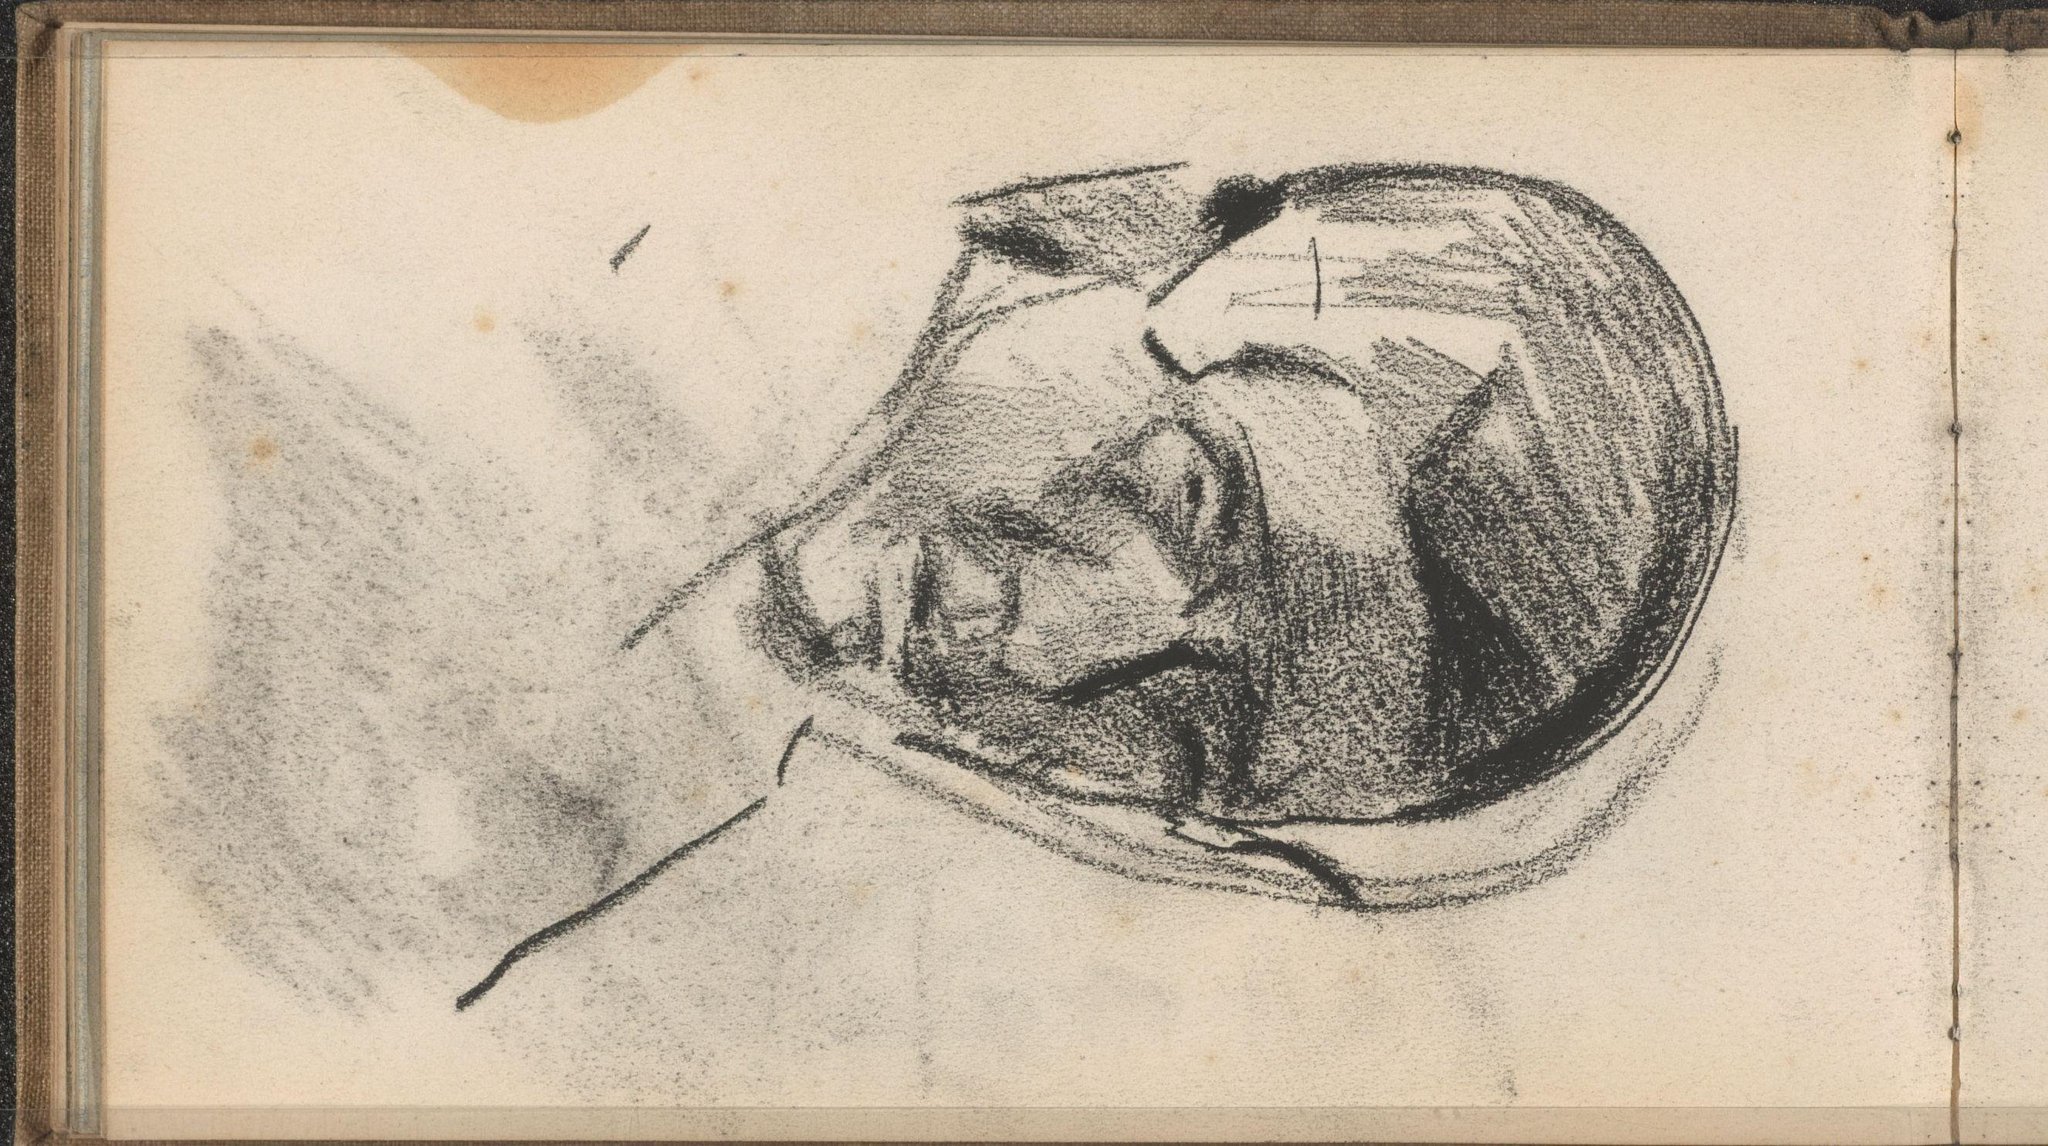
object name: sketchbook leaf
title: Vrouwenhoofd met muts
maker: george hendrik breitner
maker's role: draughtsman, painter, print maker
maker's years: 1857-1923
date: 1883-1885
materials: chalk, paper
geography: drenthe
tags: head-gear (+ women's clothes), head (human) - aa - female human figure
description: Pagina 59 uit een schetsboek met 48 bladen.